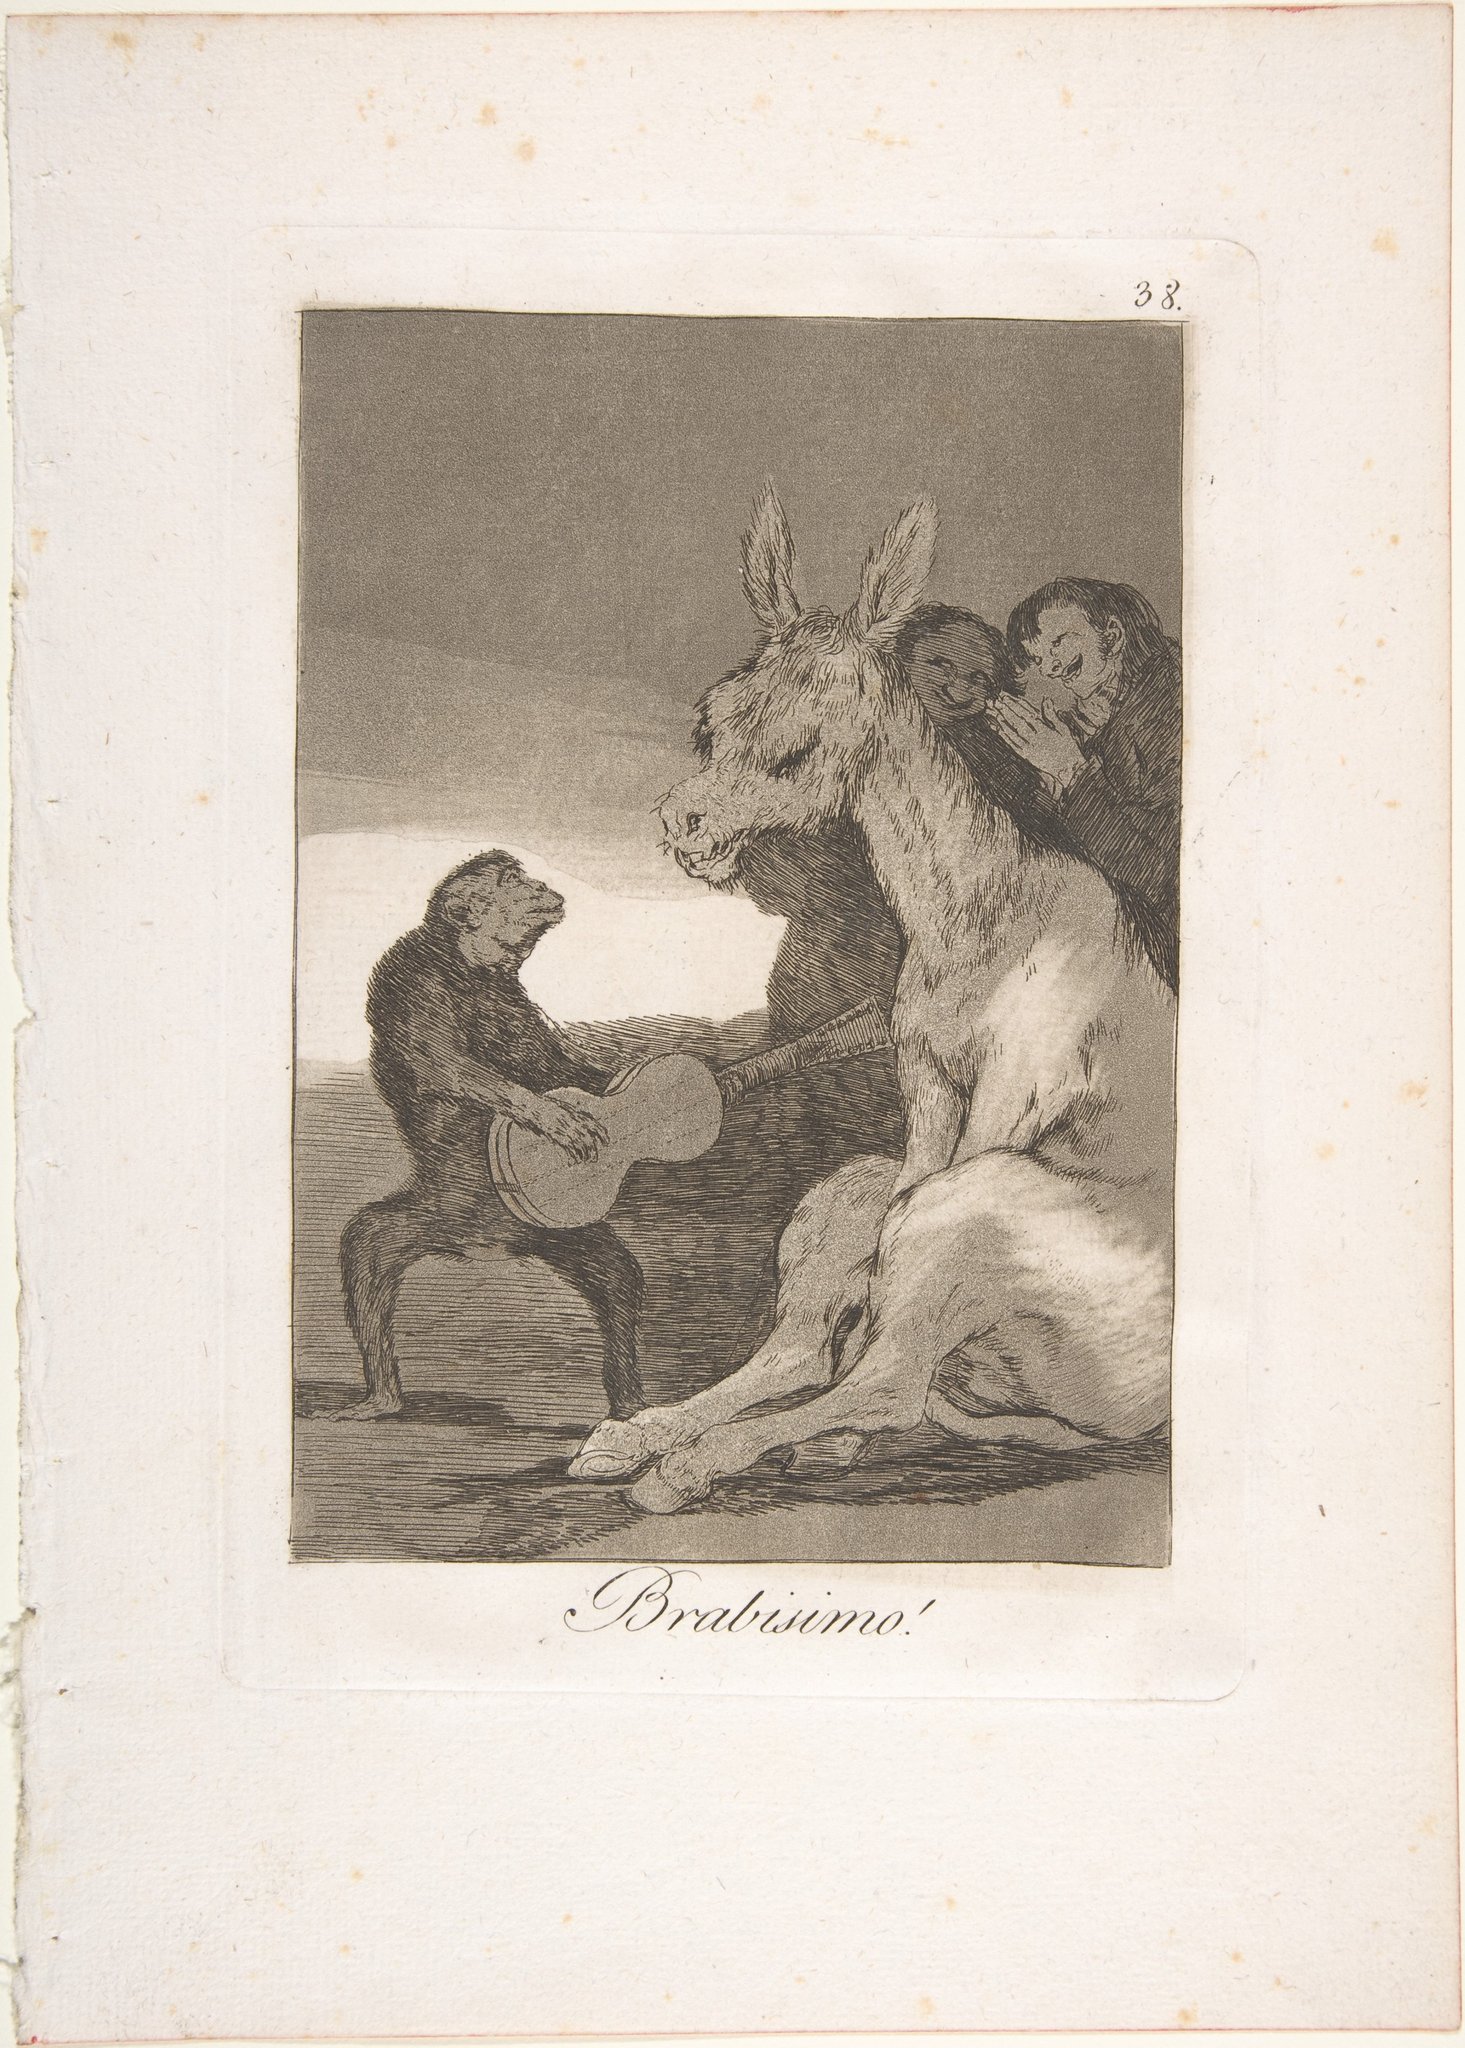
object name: print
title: Plate 38 from "Los Caprichos": Bravo! (Brabisimo!)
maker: goya (francisco de goya y lucientes)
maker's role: artist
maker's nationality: spanish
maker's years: 1746-1828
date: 1799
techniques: aquatint, burnishing, drypoint, etching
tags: music,guitars,donkeys,monkeys